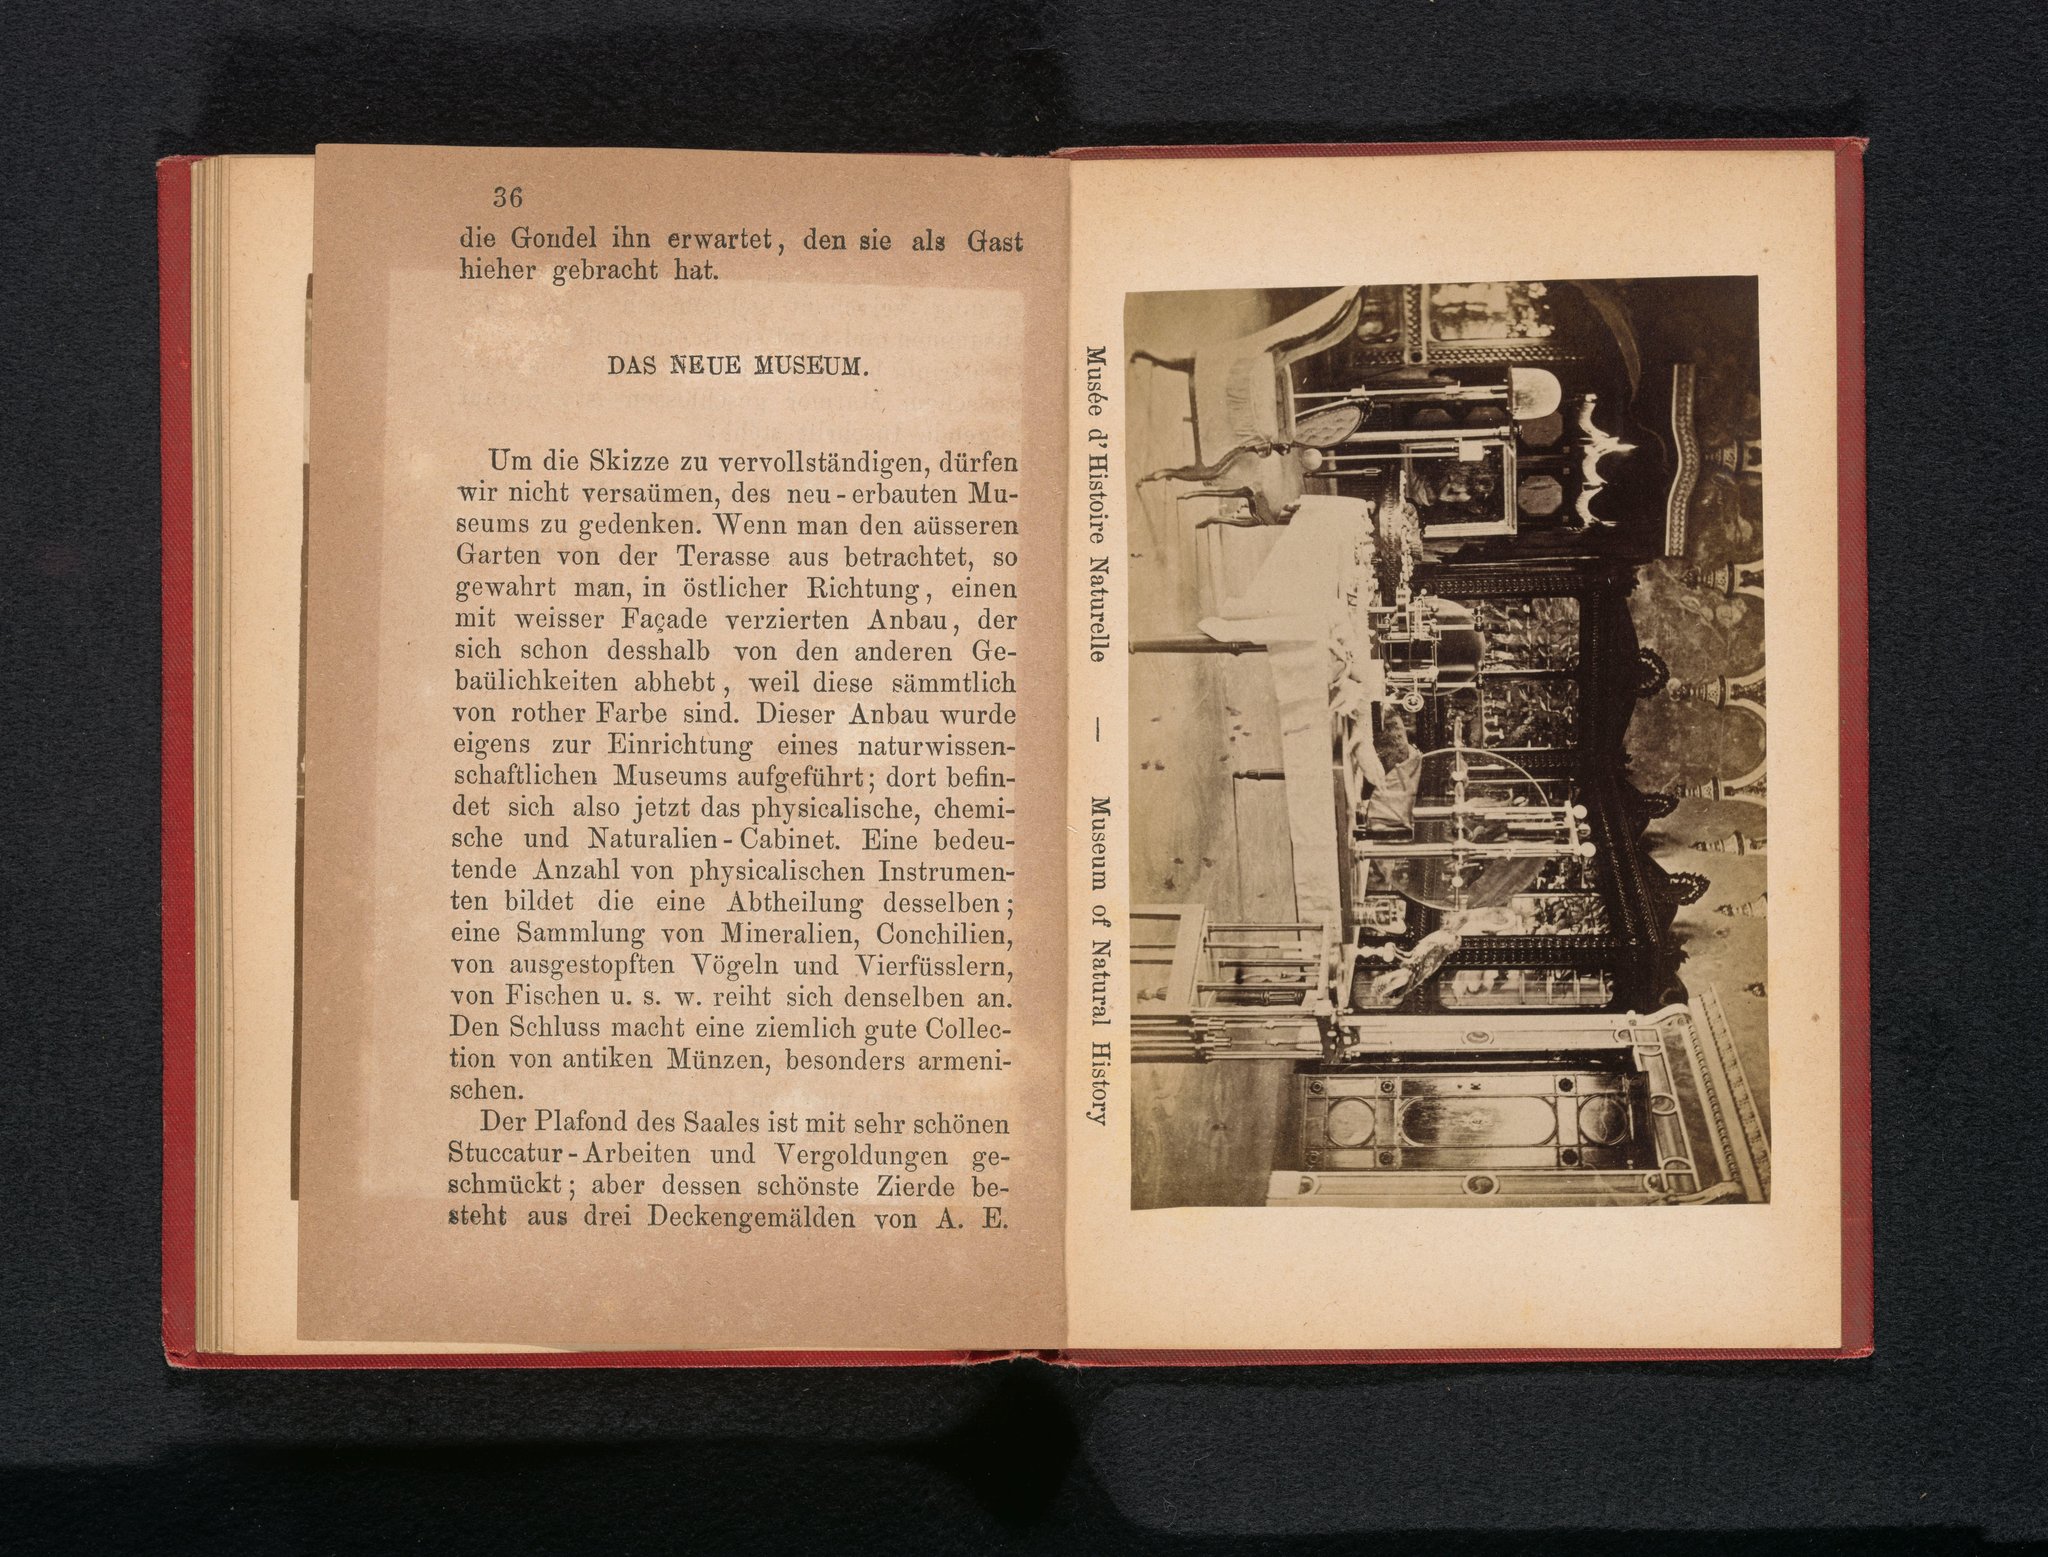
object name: photograph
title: Cemetery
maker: Anonymous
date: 1870-1880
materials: paper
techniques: albumen print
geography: san lazzaro degli armeni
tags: churchyard, cemetery